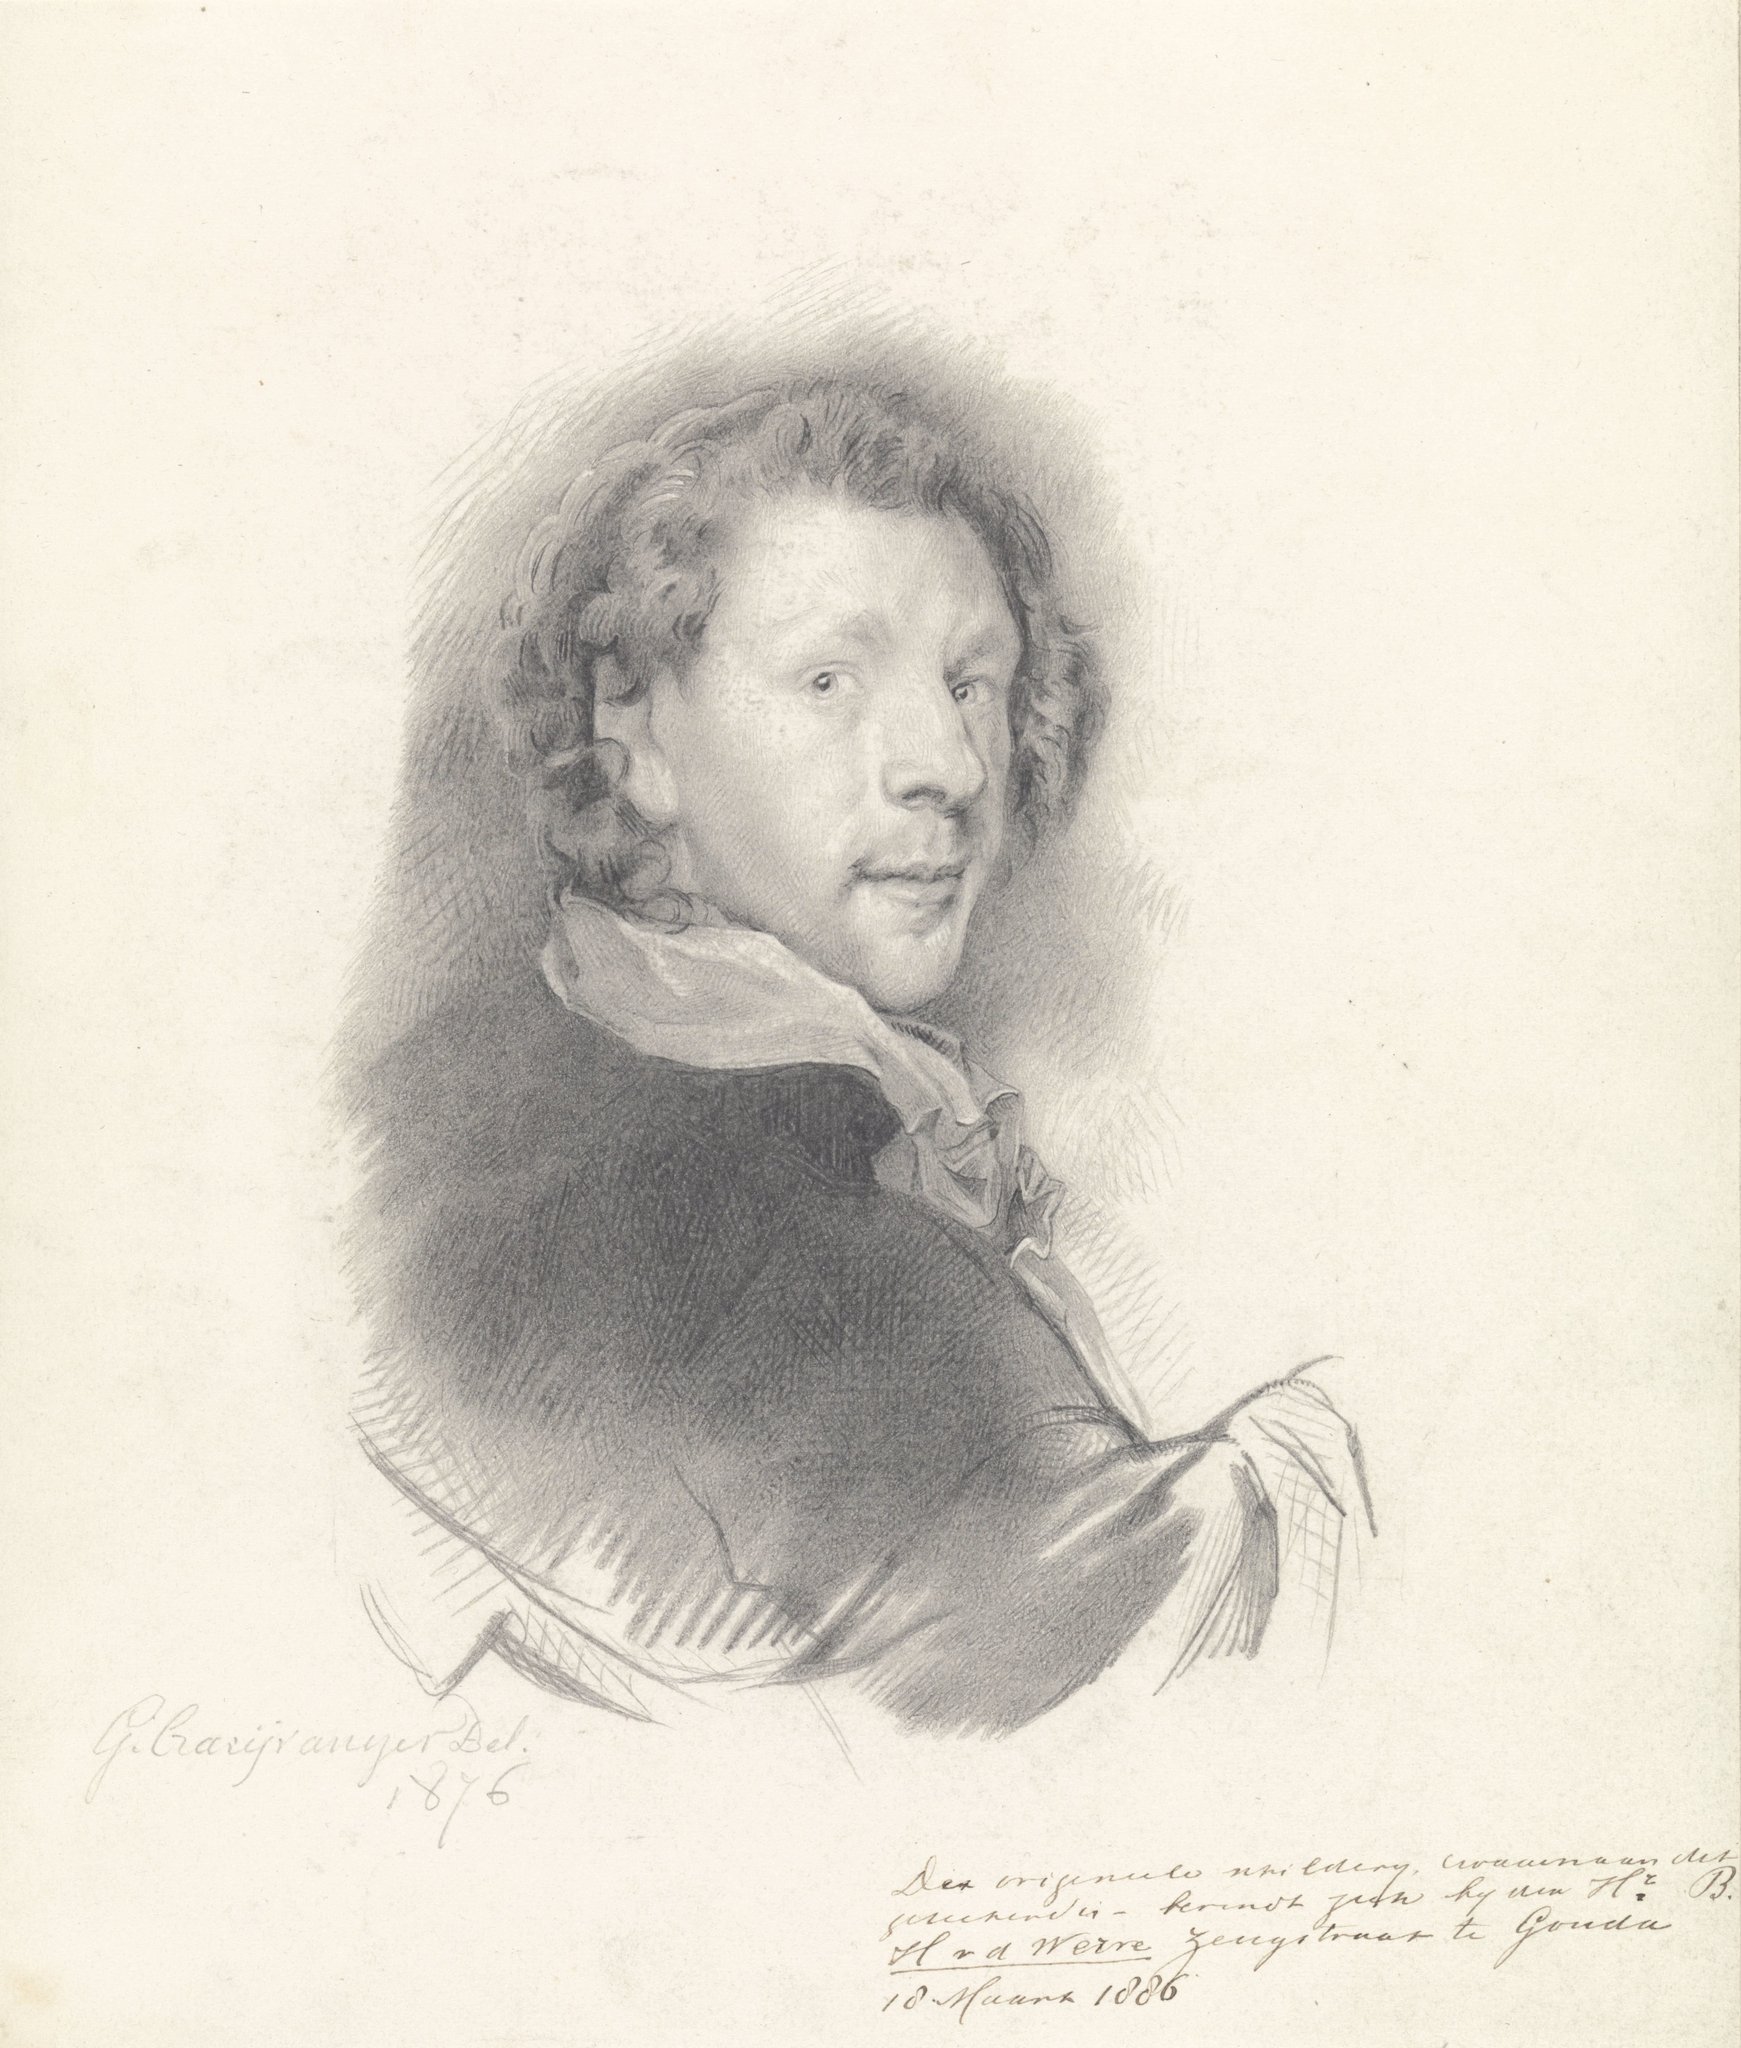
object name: drawing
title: Zelfportret van Gijsbertus Craeyvanger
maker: gijsbertus craeyvanger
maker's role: draughtsman, print maker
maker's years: 1810-1895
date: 1876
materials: paper, pencil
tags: utrecht, gijsbertus craeyvanger, historical persons, portrait, self-portrait of painter, portrait, self-portrait of artist, portrait, self-portrait of draughtsman